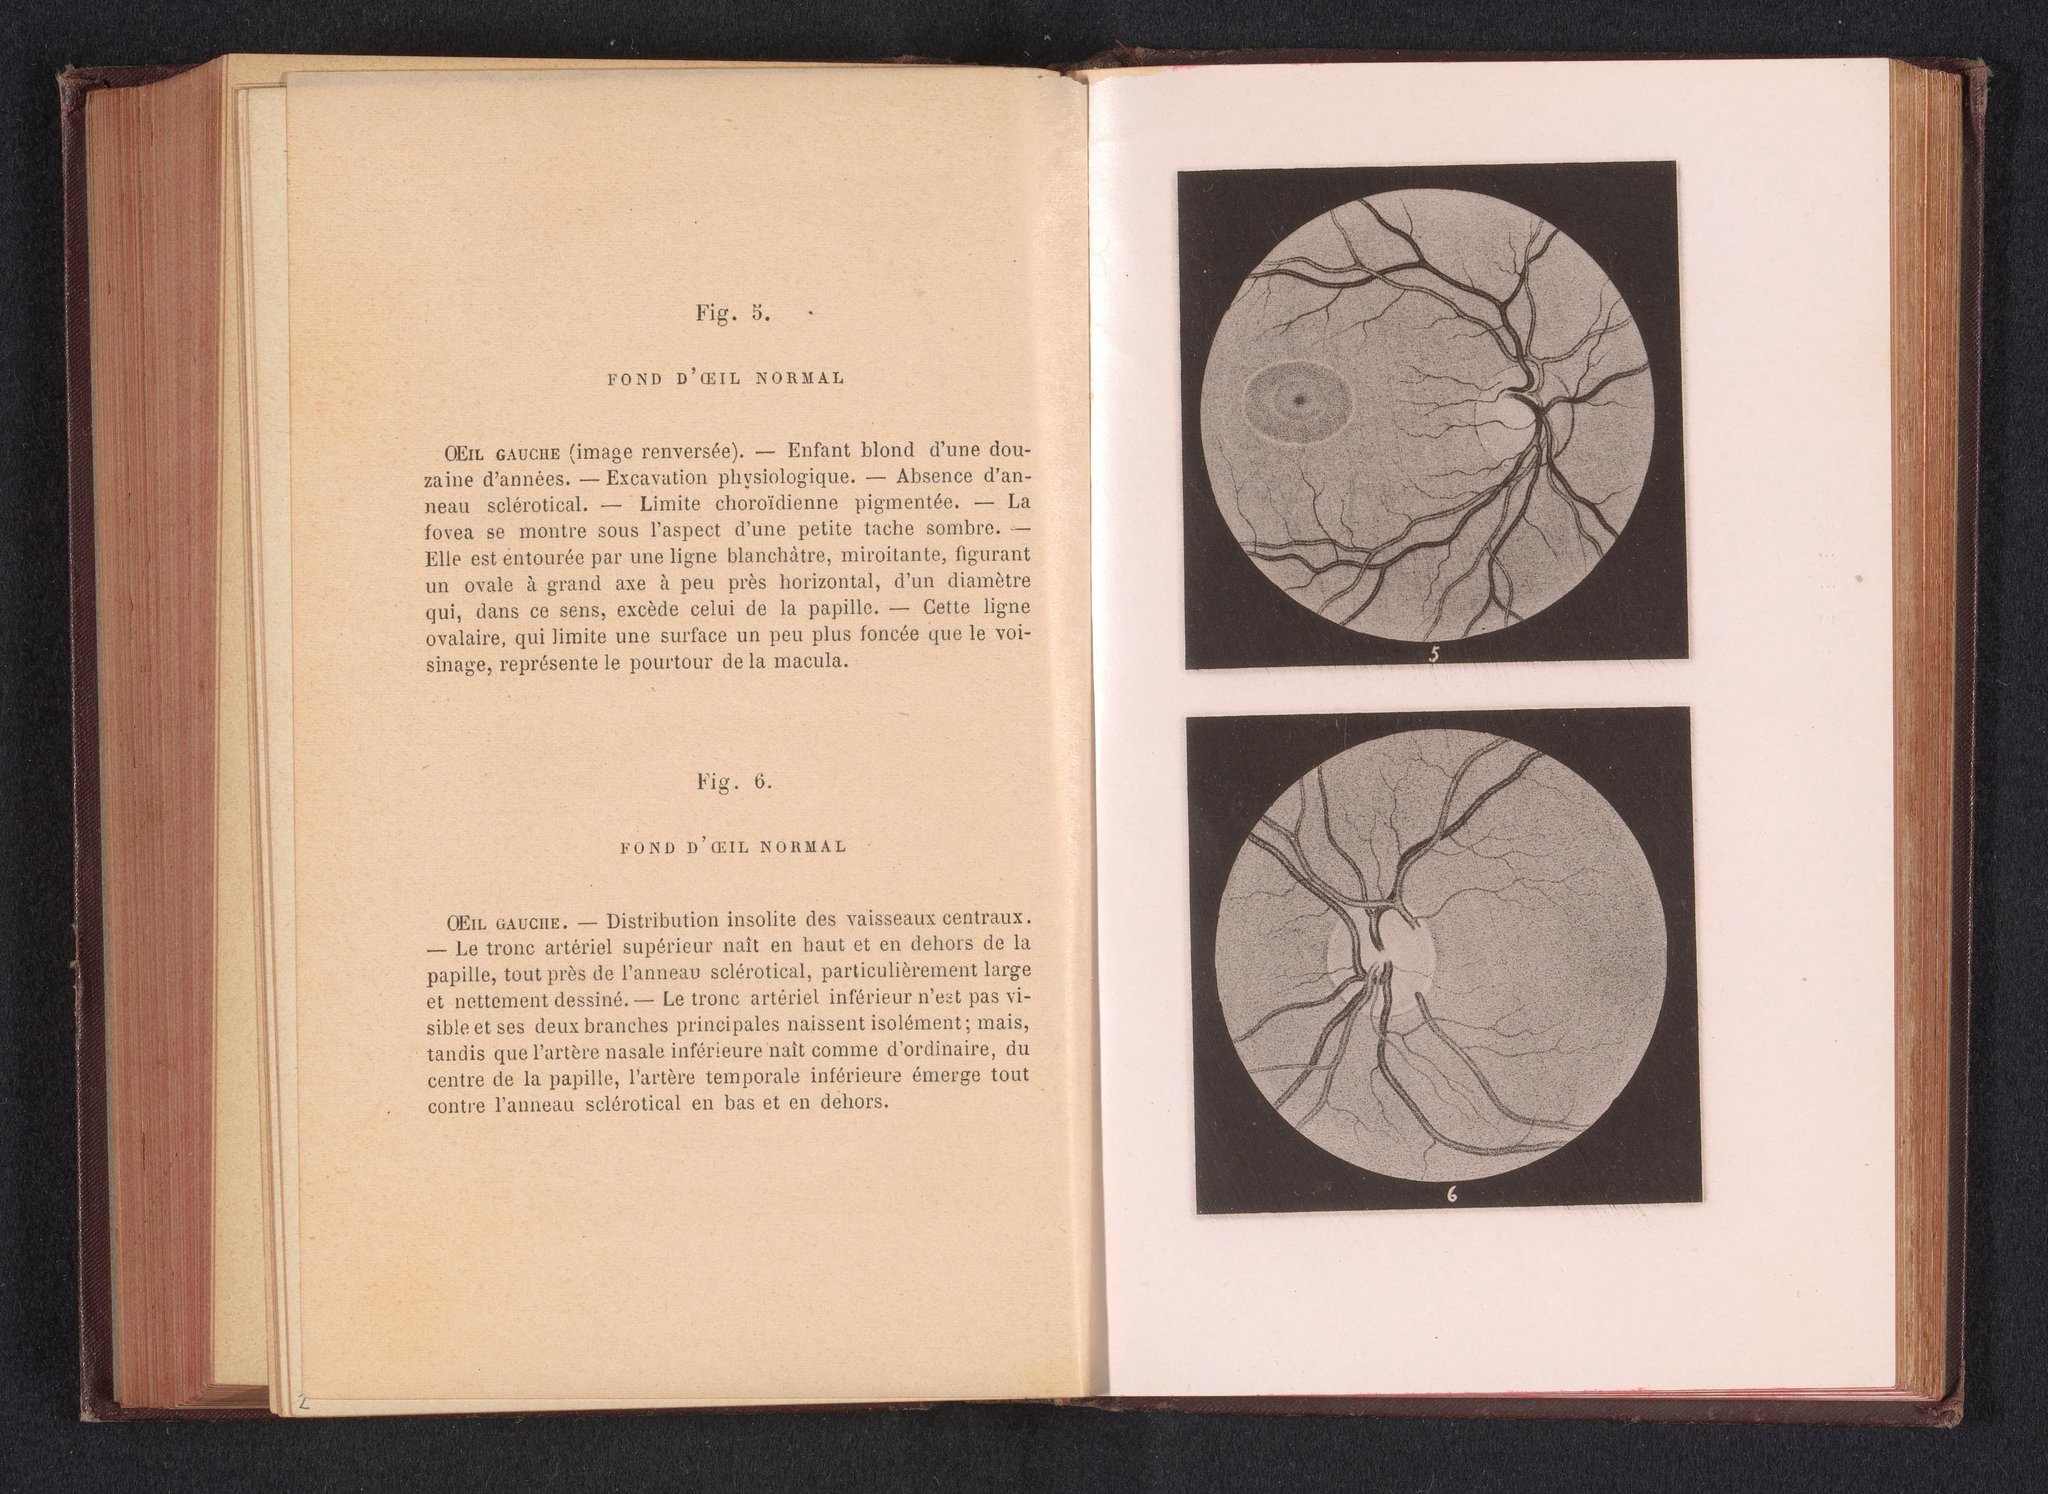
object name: page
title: Fotoreproductie van twee anatomische tekeningen van een normaal oog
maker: Anonymous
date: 1871-1891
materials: paper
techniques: photograph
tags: anatomy (non-medical), eyes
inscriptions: inscription: ‘Fig. 5. Fond d'oeil normal Fig. 6. Fond d'oeil normal’